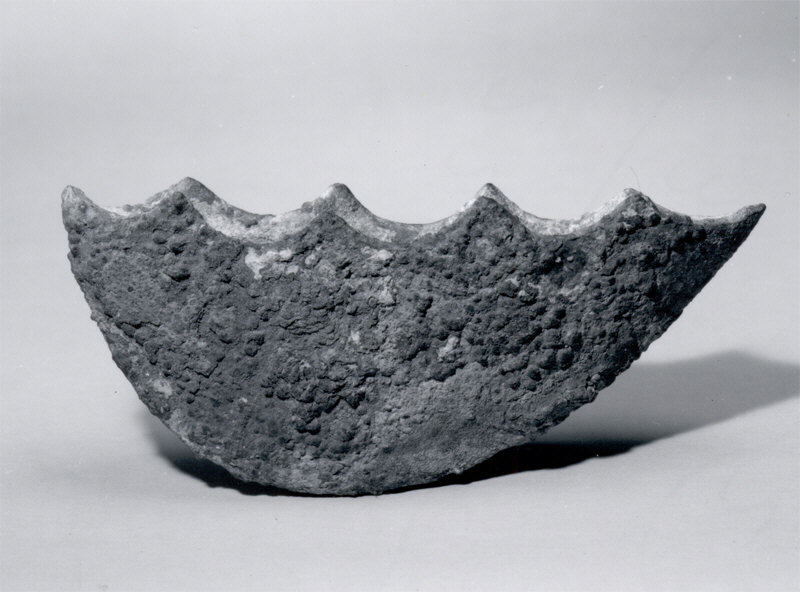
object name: implement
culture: bactria-margiana archaeological complex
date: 2333-1668 BCE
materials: copper alloy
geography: bactria-margiana